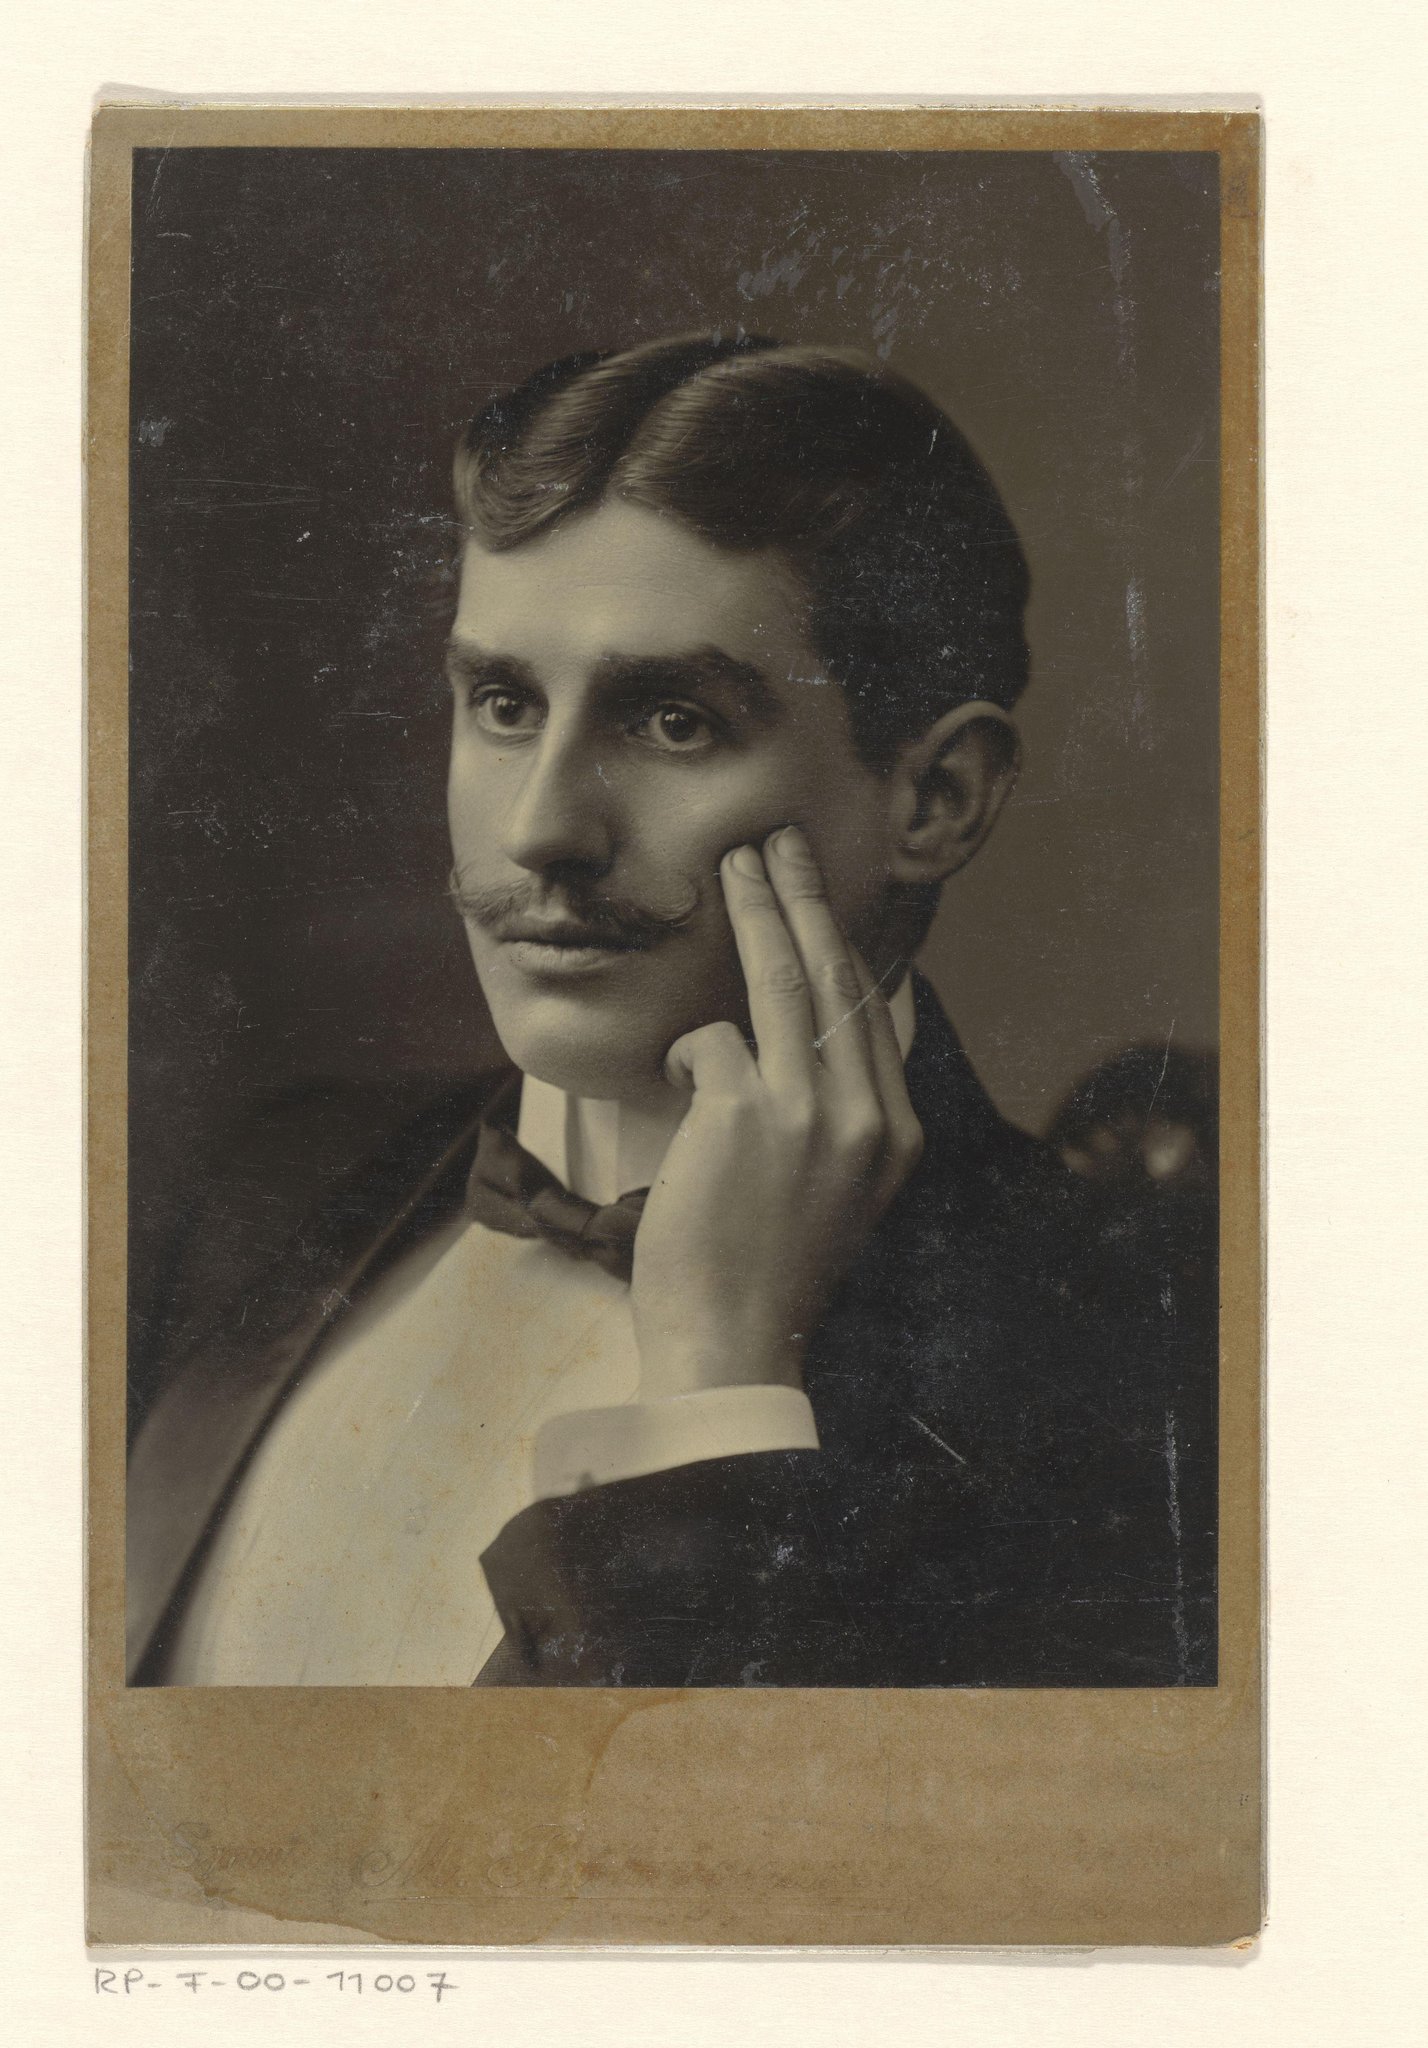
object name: photograph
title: Portret van een onbekende man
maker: büttinghausen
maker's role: fotograaf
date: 1886-1906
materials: cardboard, photographic support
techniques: collodion silver print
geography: amsterdam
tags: historical persons not known by name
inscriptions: inscription: ‘M. Büttinghausen/ AMSTERDAM Spui 15 b. de Kalverstraat/ eenig Atelier.’, inscription: ‘Spui 15/ M. Büttinghausen Eenig Atelier’, :, collector's mark: Lugt 2228a